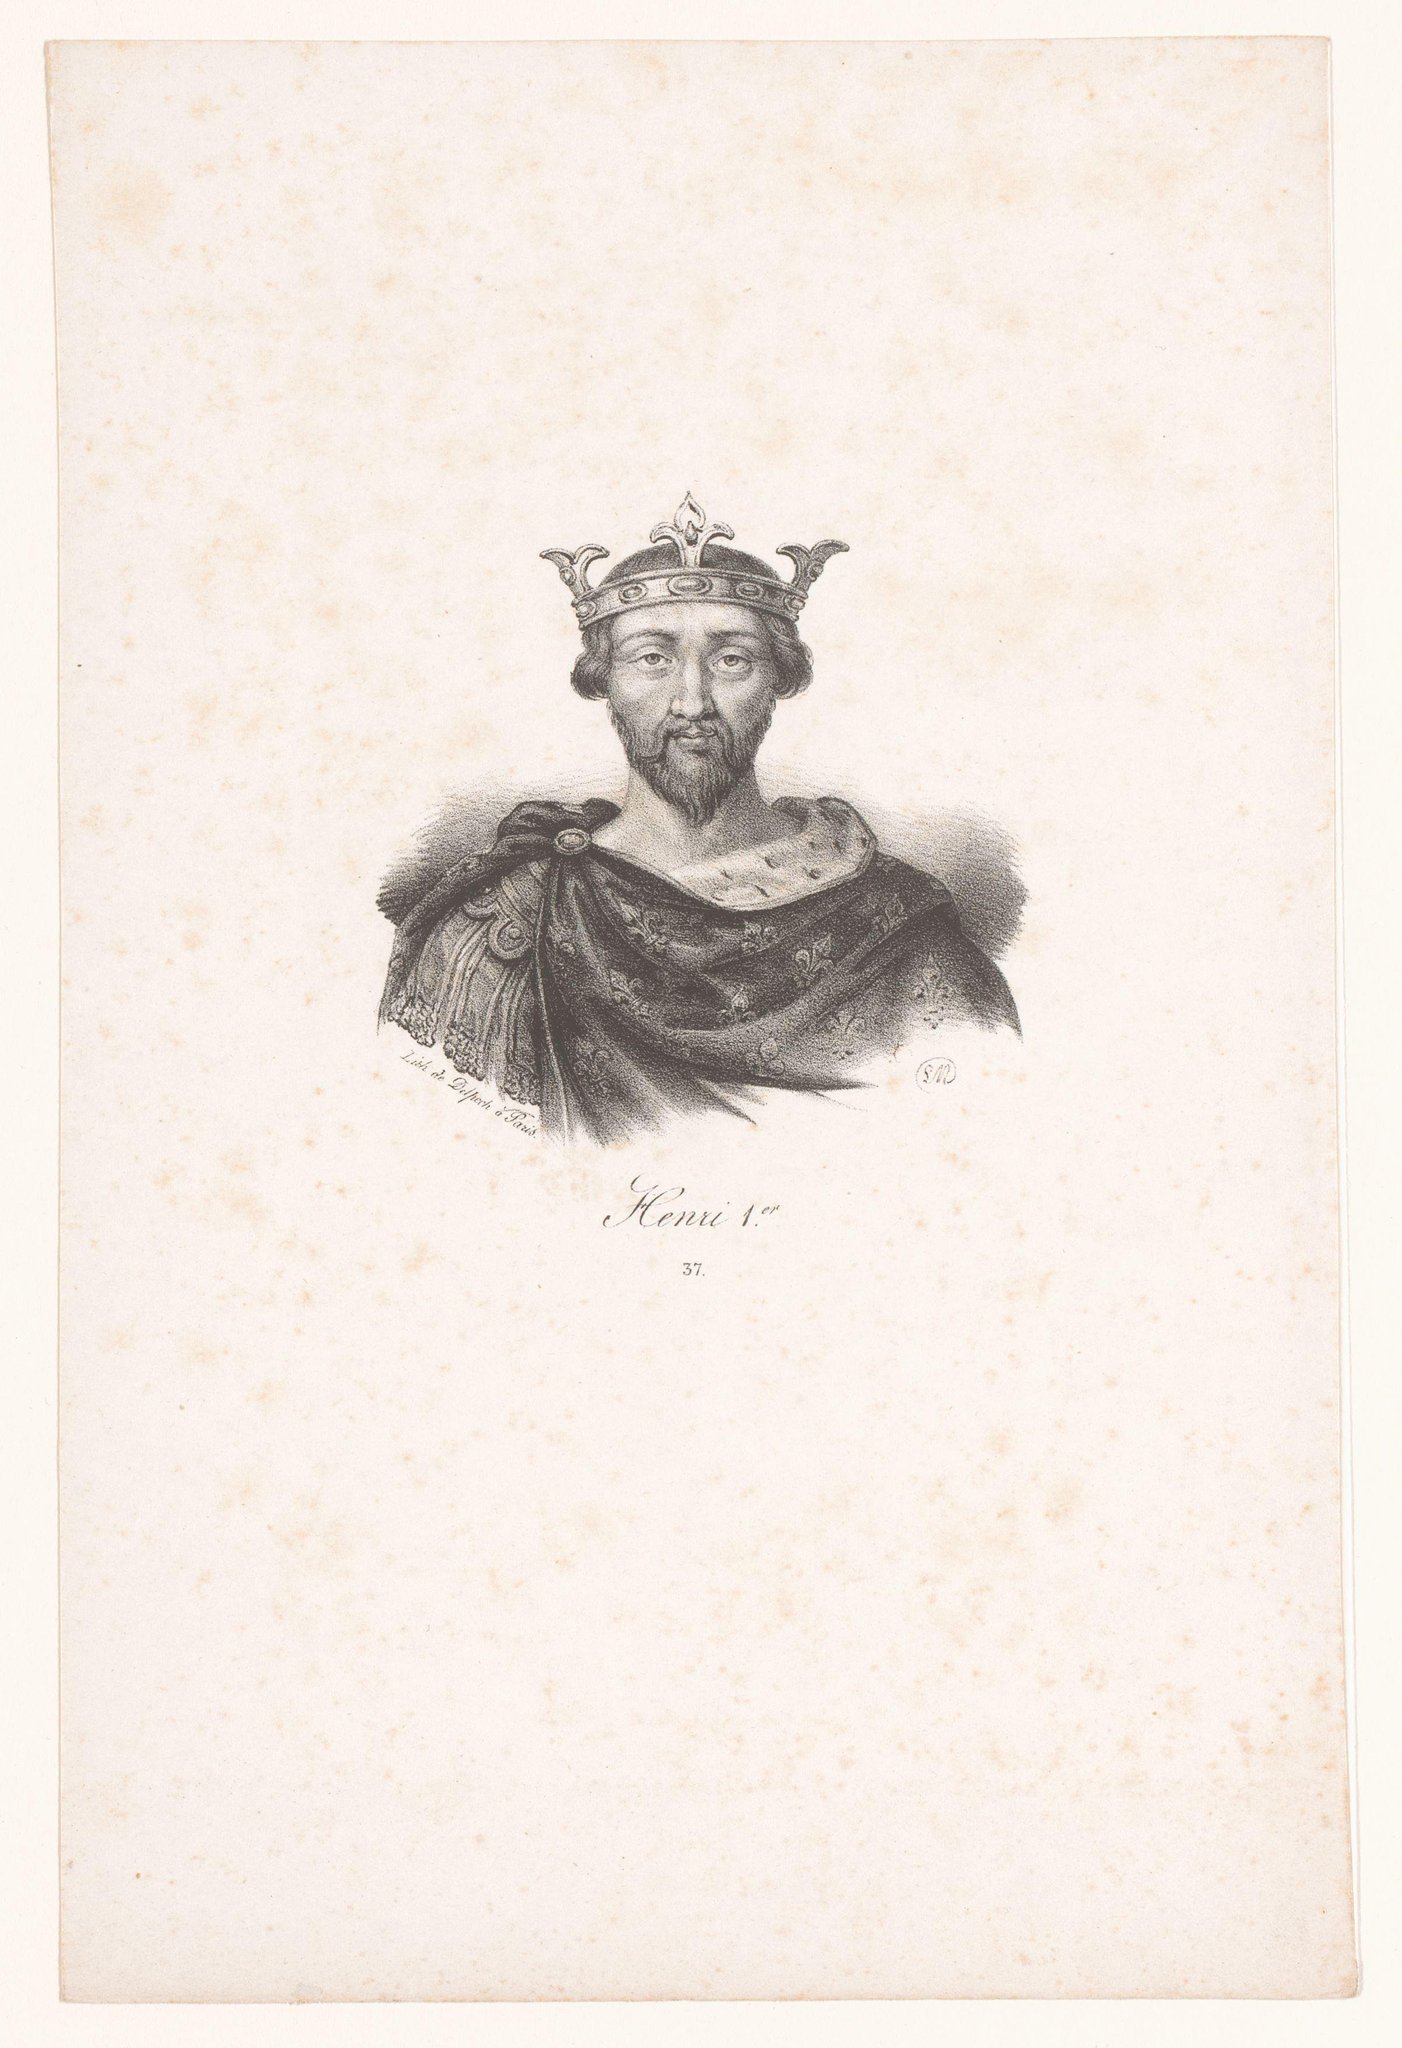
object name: print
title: Henri Ier.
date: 1825-1842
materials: paper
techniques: lithograph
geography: paris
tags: historical persons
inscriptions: collector's mark: Lugt 2228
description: Prent waarschijnlijk gebruikt voor: Rois et reines de France: depuis l'origine de la monarchie jusqu'à nos jours. 3 dln. Parijs: veuve Delpech, 1833-1840. En/of voor: Iconographie française ou recueil des portraits des personnages les plus illustres qui ont paru en France depuis François premier jusqu'à la fin du règne de Louis XVI (…). Parijs: veuve Delpech, 1828. En/of voor: Iconographie française ou choix de deux cents portraits d'hommes et de femmes qui se sont acquis en France, depuis le règne de Charles VII jusqu'à la fin de celui de Louis XVI (…). Parijs: veuve Delpech, 1840. Mogelijk komt de prent ook voor in eerdere en/of latere publicaties uitgegeven door veuve Delpech of haar opvolger Rosselin.